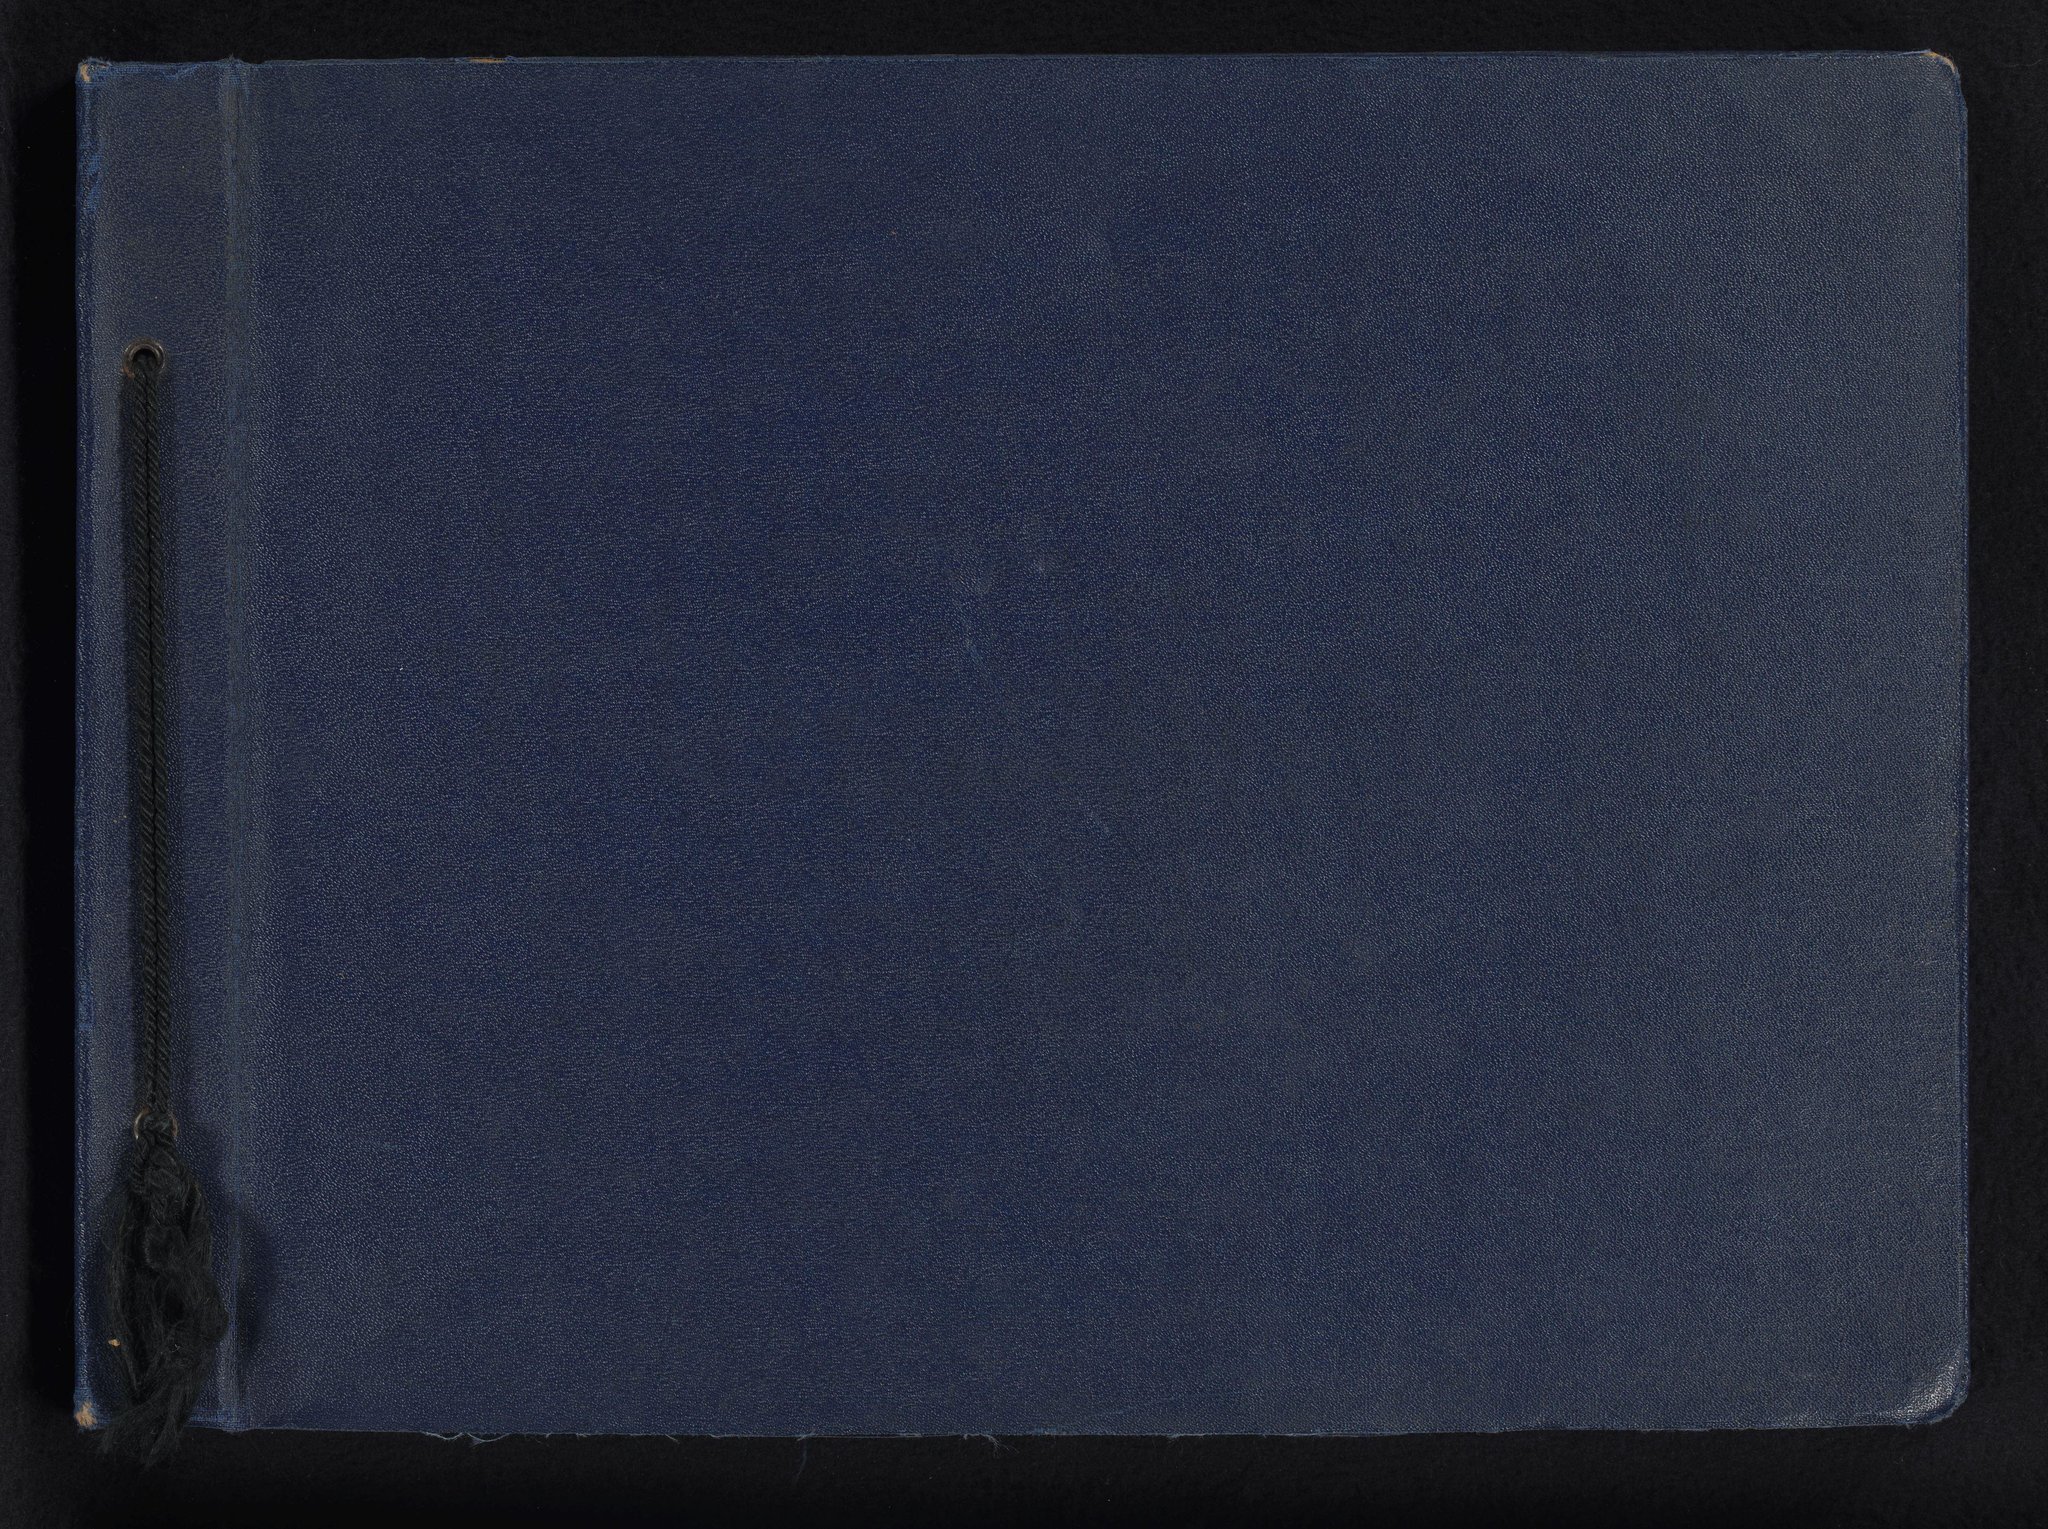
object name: photograph album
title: Duits militair album Tweede Wereldoorlog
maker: Anonymous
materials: cardboard, photographic support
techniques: gelatin silver print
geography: germany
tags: netherlands, germany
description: Duits militair fotoalbum met een blauw linnen kaft. Het album bevat 24 bladen van bruin karton met 144 foto's, spinrag papier ertussen. Koordje door de rug. Het betreft een album van een militair die vermoedelijk radiotelegrafist bij de Luftwaffe was. Alle foto's met onderschriften. In 1939 en 1940 veel foto's van de militaire scholing in Duitsland, diverse verblijfplaatsen en vakanties thuis. Met 'Belgien und Holland geschlagen' begint het deel over Nederland. De samensteller van het album laat zich fotograferen met een Nederlandse helm op, ook foto's van niet ontplofte Engelse bommen, Engelse vliegtuigen en schade aan huizen. Zomer 1940 is hij weer terug in Duitsland. Op 30 augustus wordt hij bevorderd tot Wachtmeister.